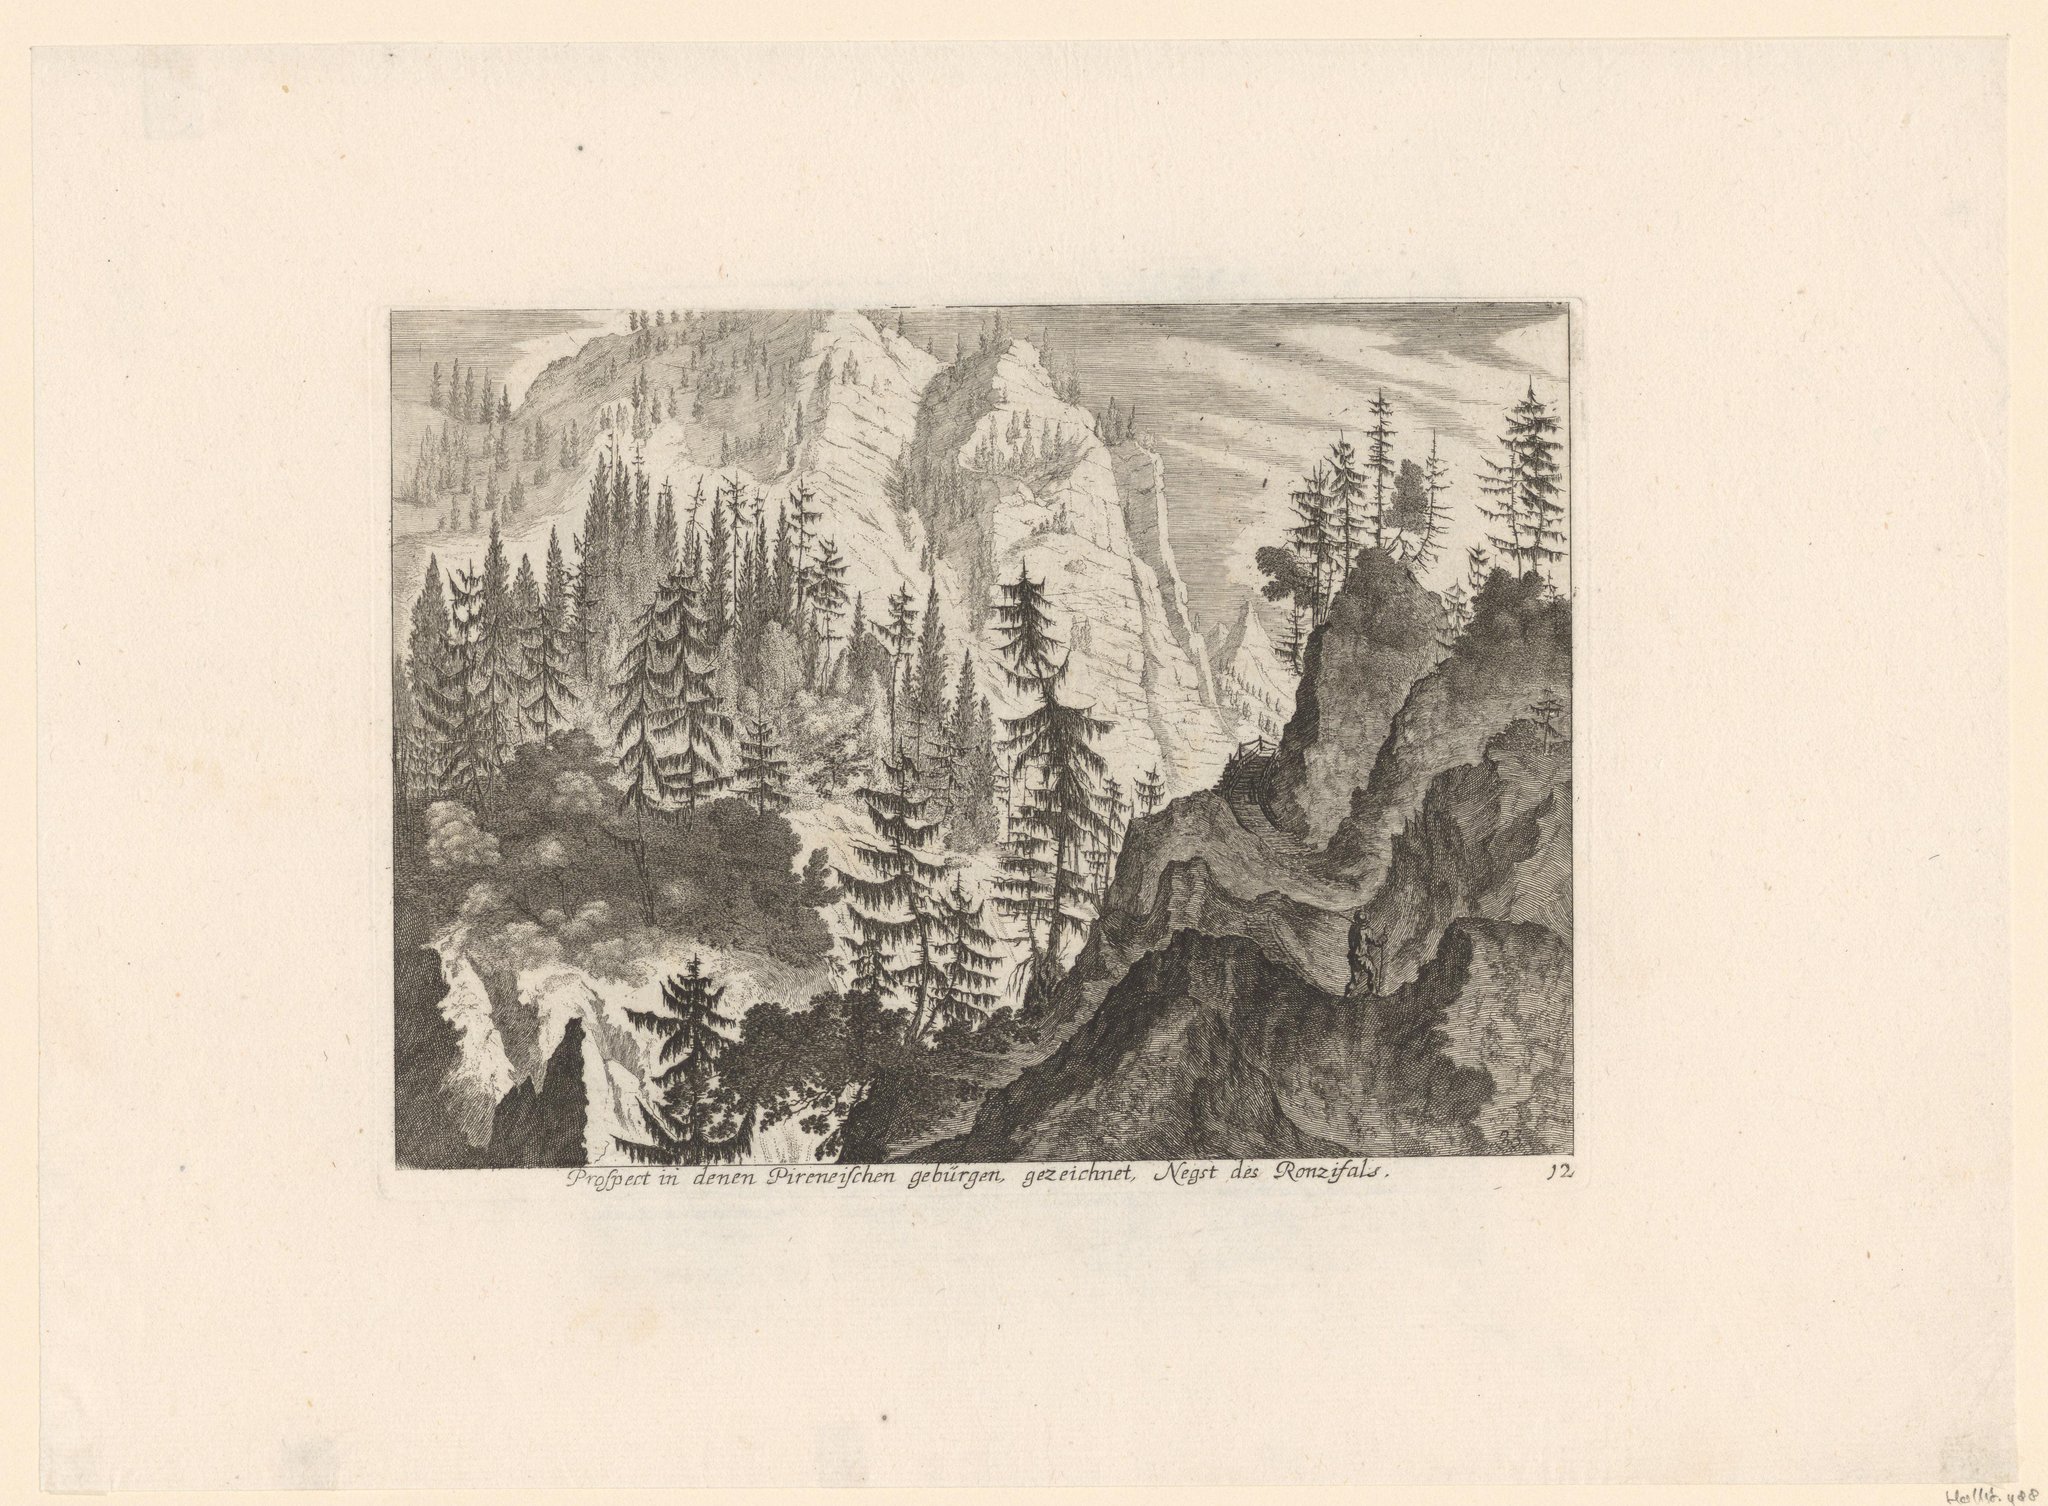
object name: print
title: Rotsachtig landschap met naaldbomen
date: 1670-1719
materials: paper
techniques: etching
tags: forest of coniferous trees, 'en route', traveller under way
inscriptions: collector's mark: Lugt 2228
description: Deze prent is deel van de serie: Schöne und Wahre Landschafften in Italien und andern Landern. Augsburg: Johann Ulrich Kraus, 1675-1685. De serie bestaat uit veertien prenten plus een titelprent. Deze uitgave omvat een selectie van de 146 prenten uit de uitgave getiteld 'Joannis Guilielmi Baurn Iconographia completens in se, Passionem (...) Per Italiam, Spectatu Sunt', voor het eerst uitgegeven in Augsburg in 1670.